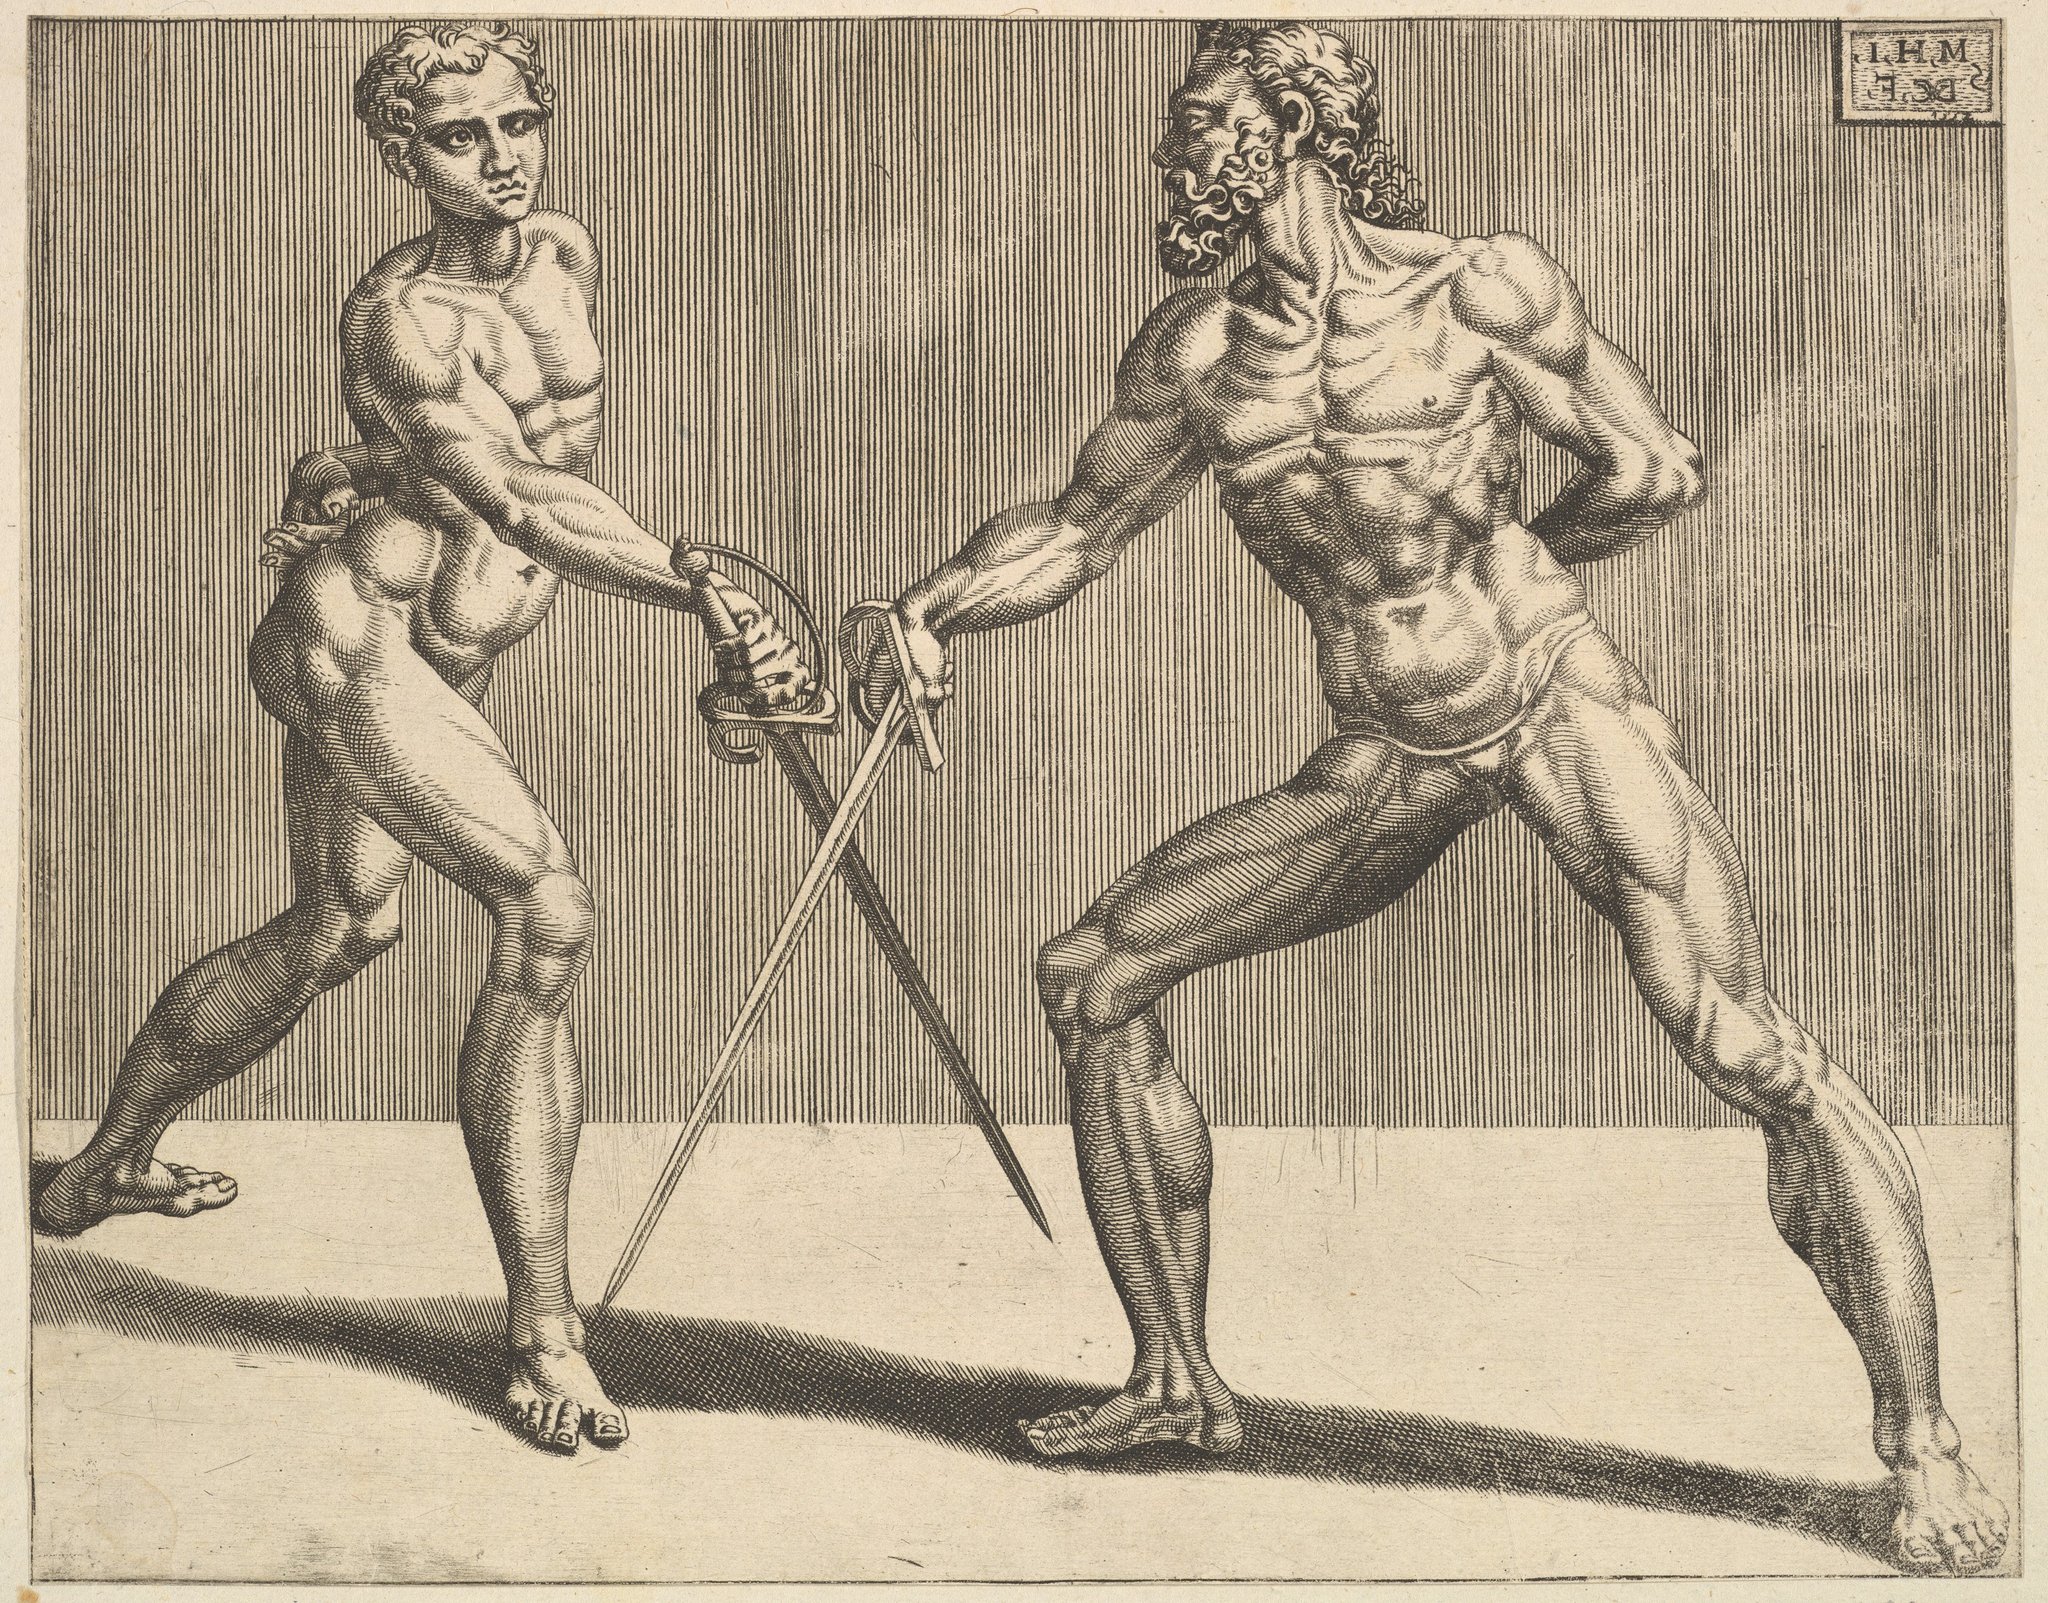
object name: print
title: Two Fencers, from Fencers, plate 5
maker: dirck volckertsz coornhert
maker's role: artist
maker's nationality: netherlandish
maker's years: 1519-1590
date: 1552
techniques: engraving, etching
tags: swords,men,male nudes,fencing